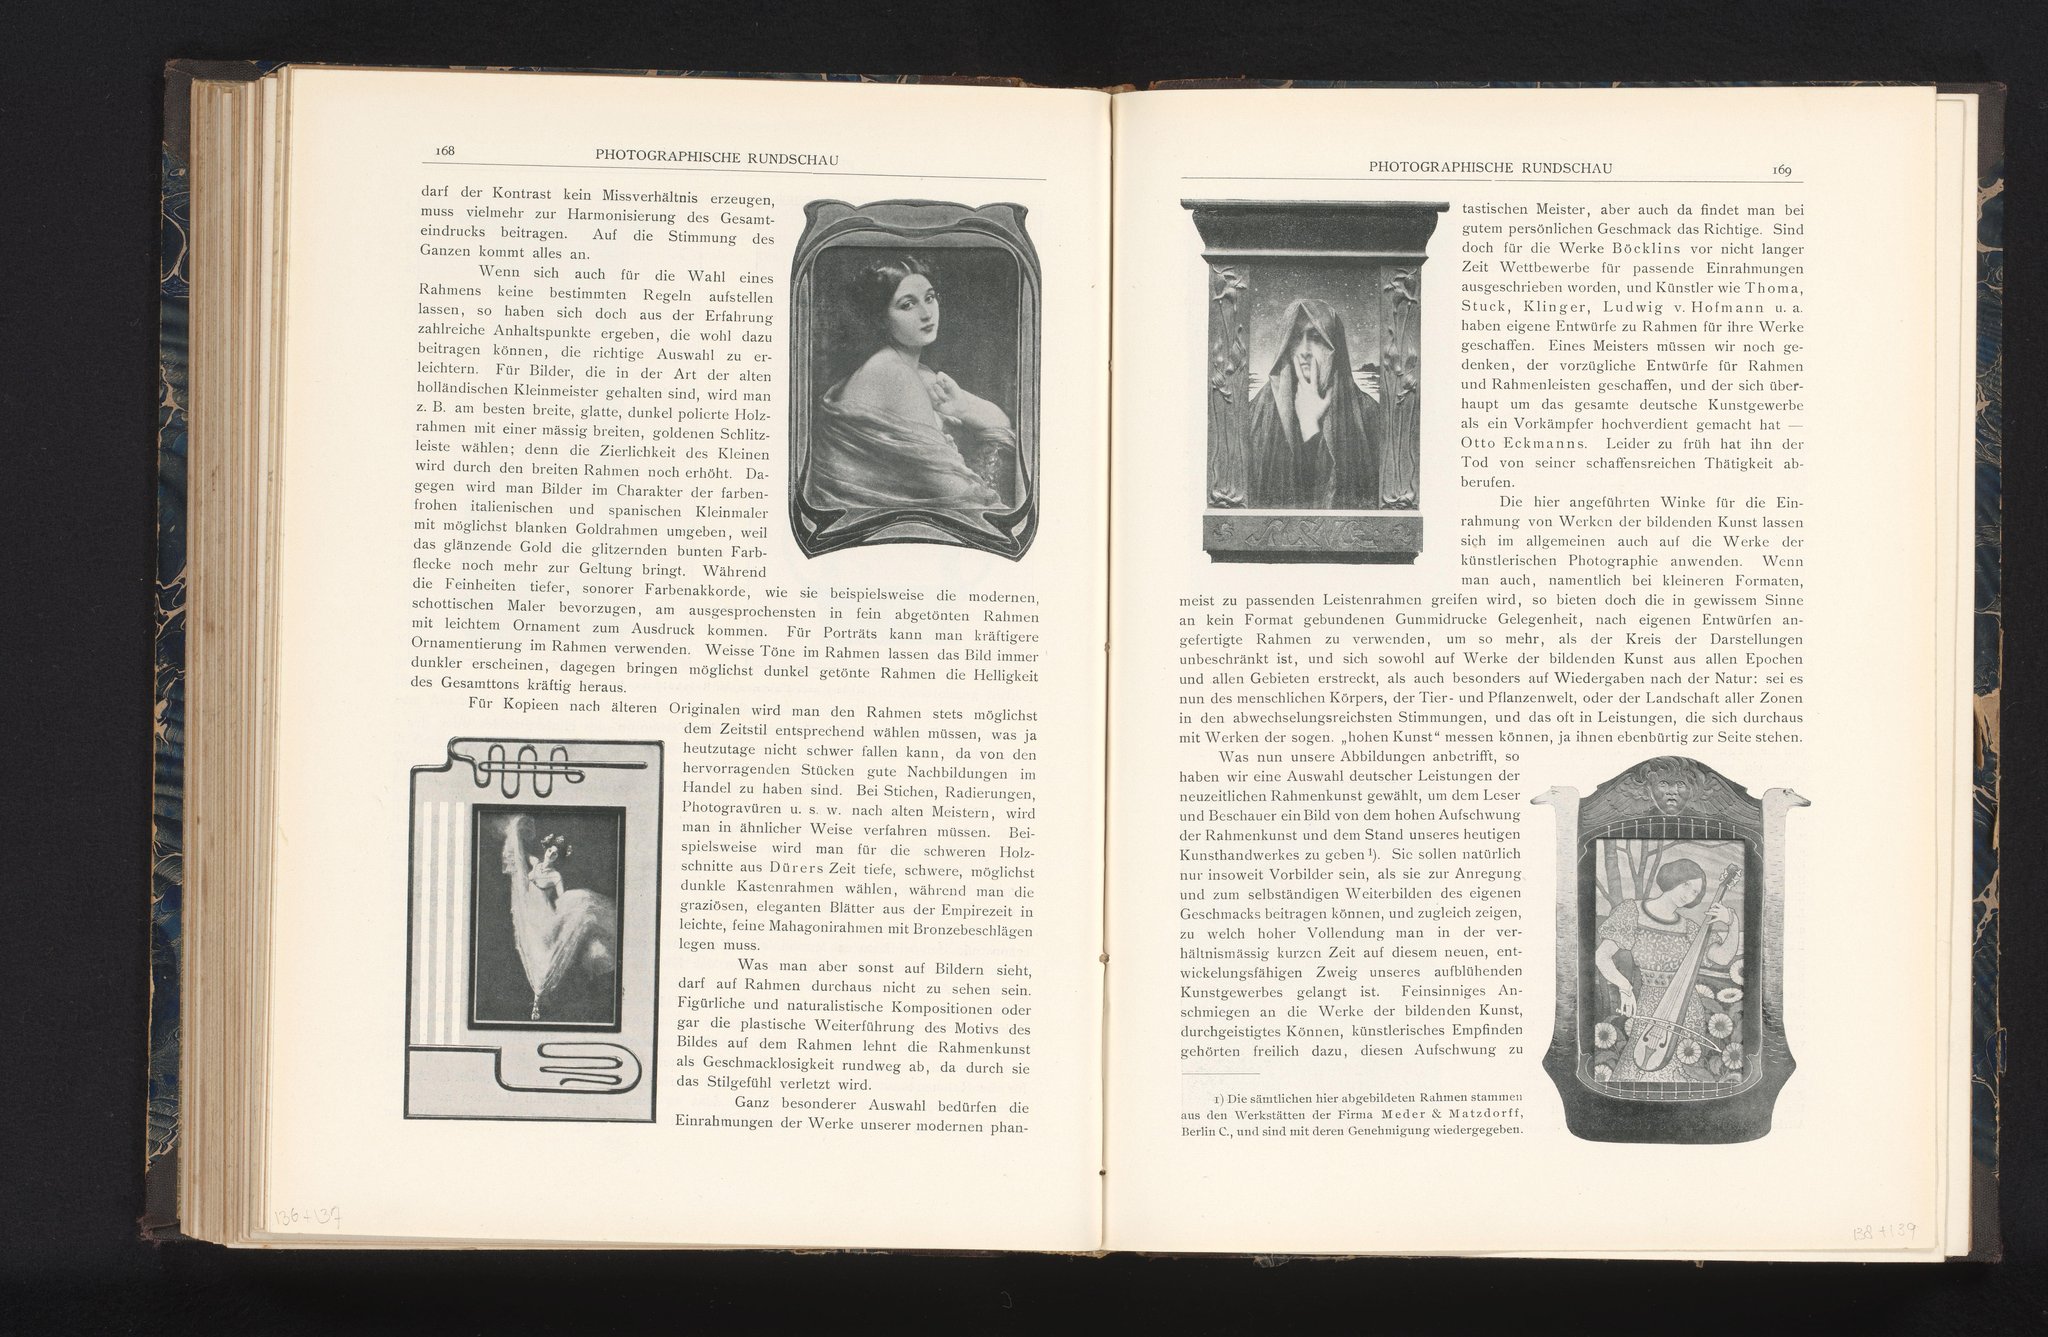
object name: page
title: Gezicht op een lijst met een portret van een onbekend persoon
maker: Anonymous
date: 1897-1902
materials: paper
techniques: autotype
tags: frame of painting, etc.